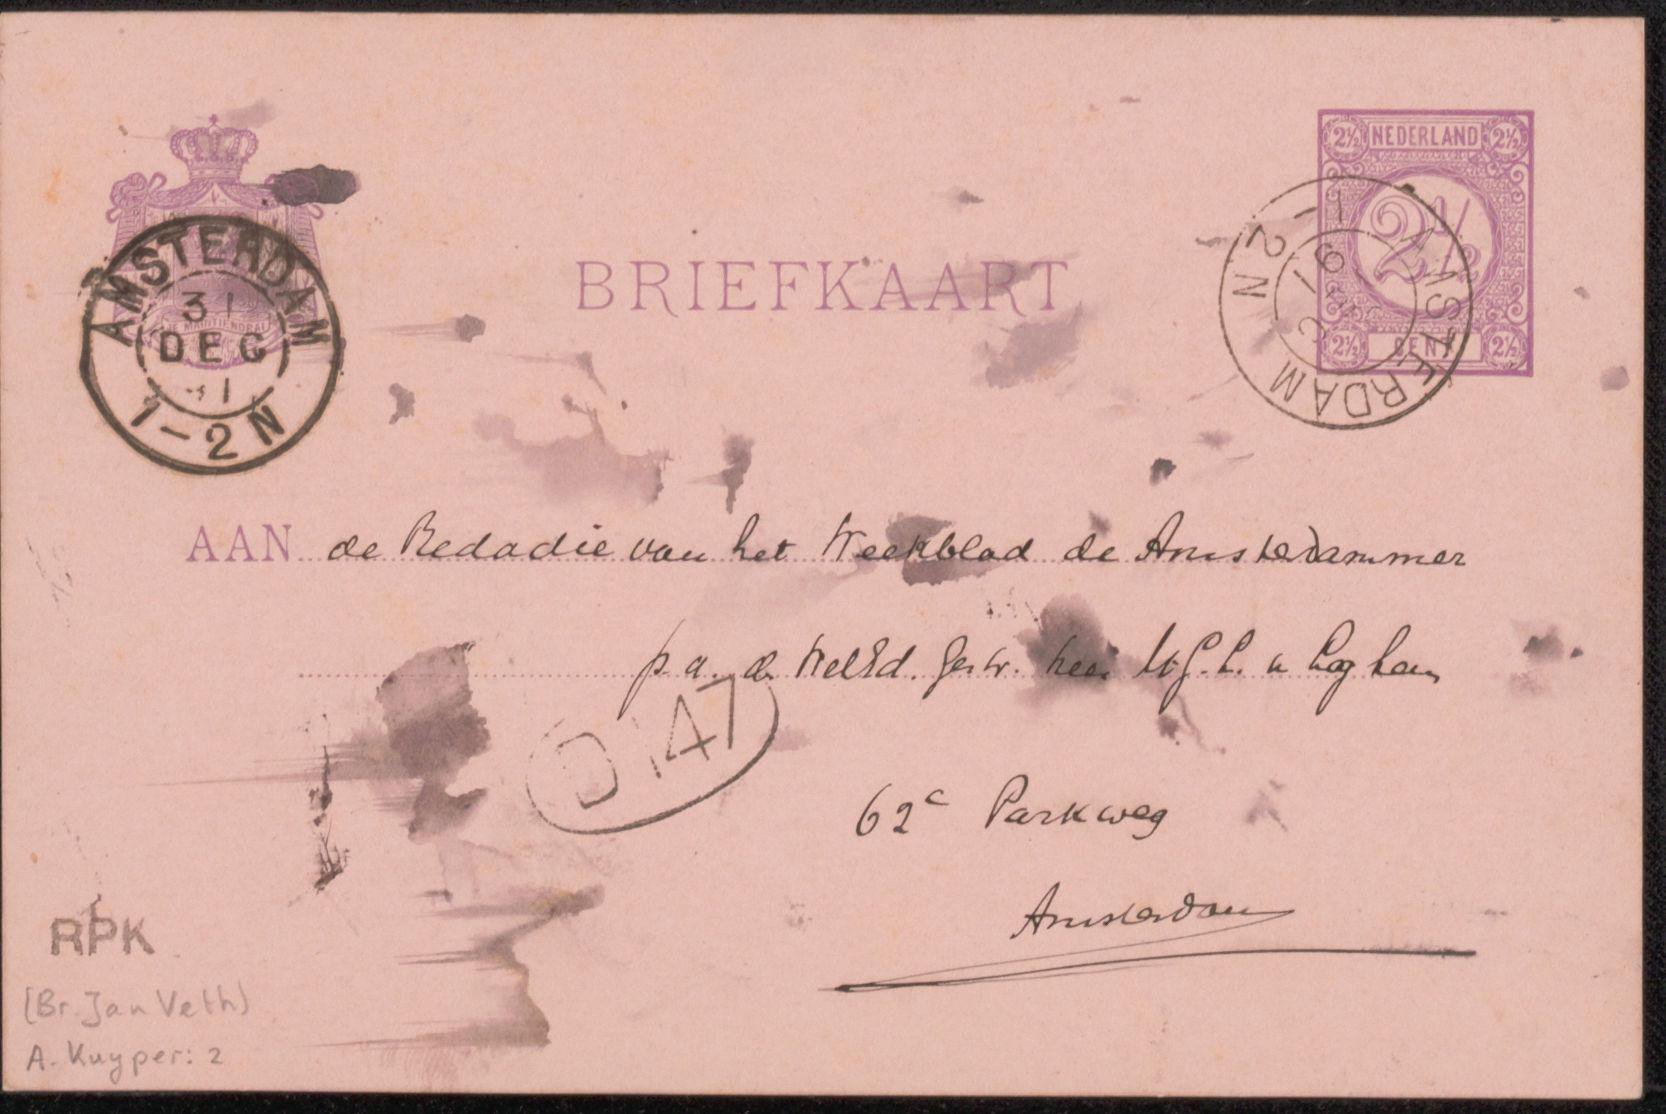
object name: postcard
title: Briefkaart aan Martinus Gesinus Lambert van Loghem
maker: abraham kuyper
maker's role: eerste kamerlid, minister van staat, tweede kamerlid, lid tweede kamer, minister, minister-president, predikant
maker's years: 1837-1920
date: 1891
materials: cardboard, ink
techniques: pen, writing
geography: amsterdam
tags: dordrecht, amsterdam, painter, draughtsman, designer, jan veth, leiden, martinus gesinus lambert van loghem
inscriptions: collector's mark: ‘RPK’